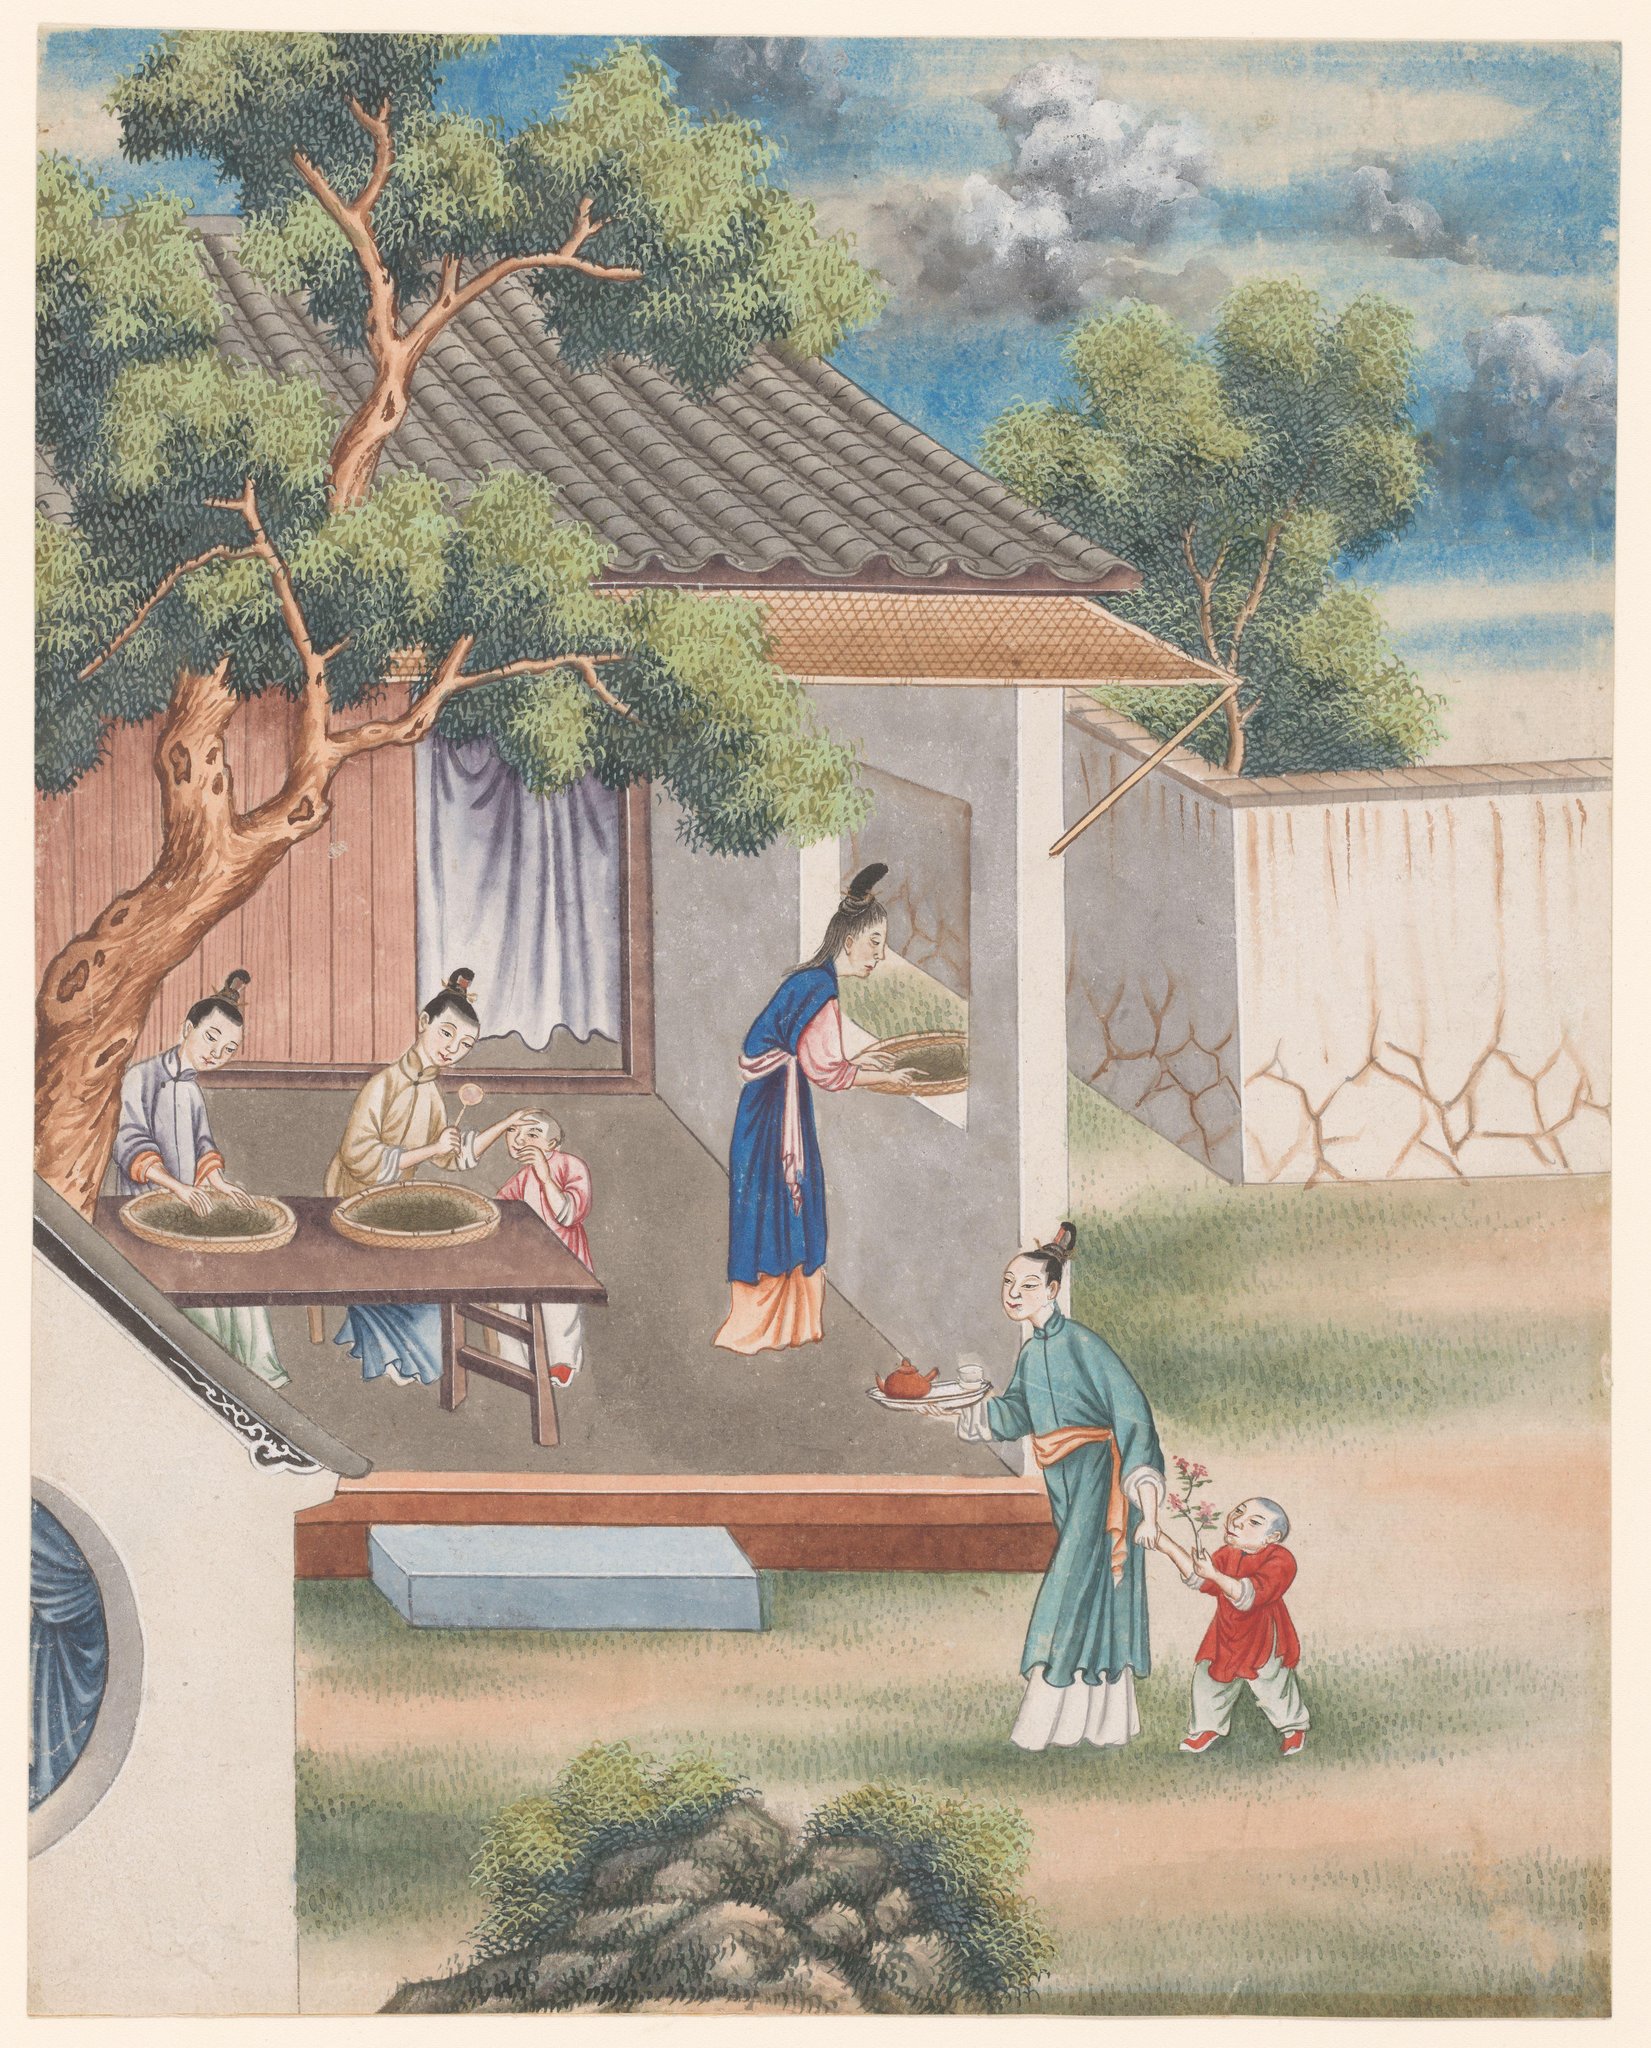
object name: drawing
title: Het sorteren van de thee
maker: Anonymous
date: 1770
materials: paint, gouache, paper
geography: china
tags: tea (leaves), control of quality, china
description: Tafel op een veranda waarachter twee Chinese vrouwen bezig zijn met het sorteren van de theeblaadjes. Naast hen een kind en een derde vrouw. Voor het huis een vrouw met een kind aan de hand en in de andere hand een blad met een theepot en een kopje. Onderdeel van een groep van vier gouaches over de productie en export van Chinese thee door de VOC rond 1750.